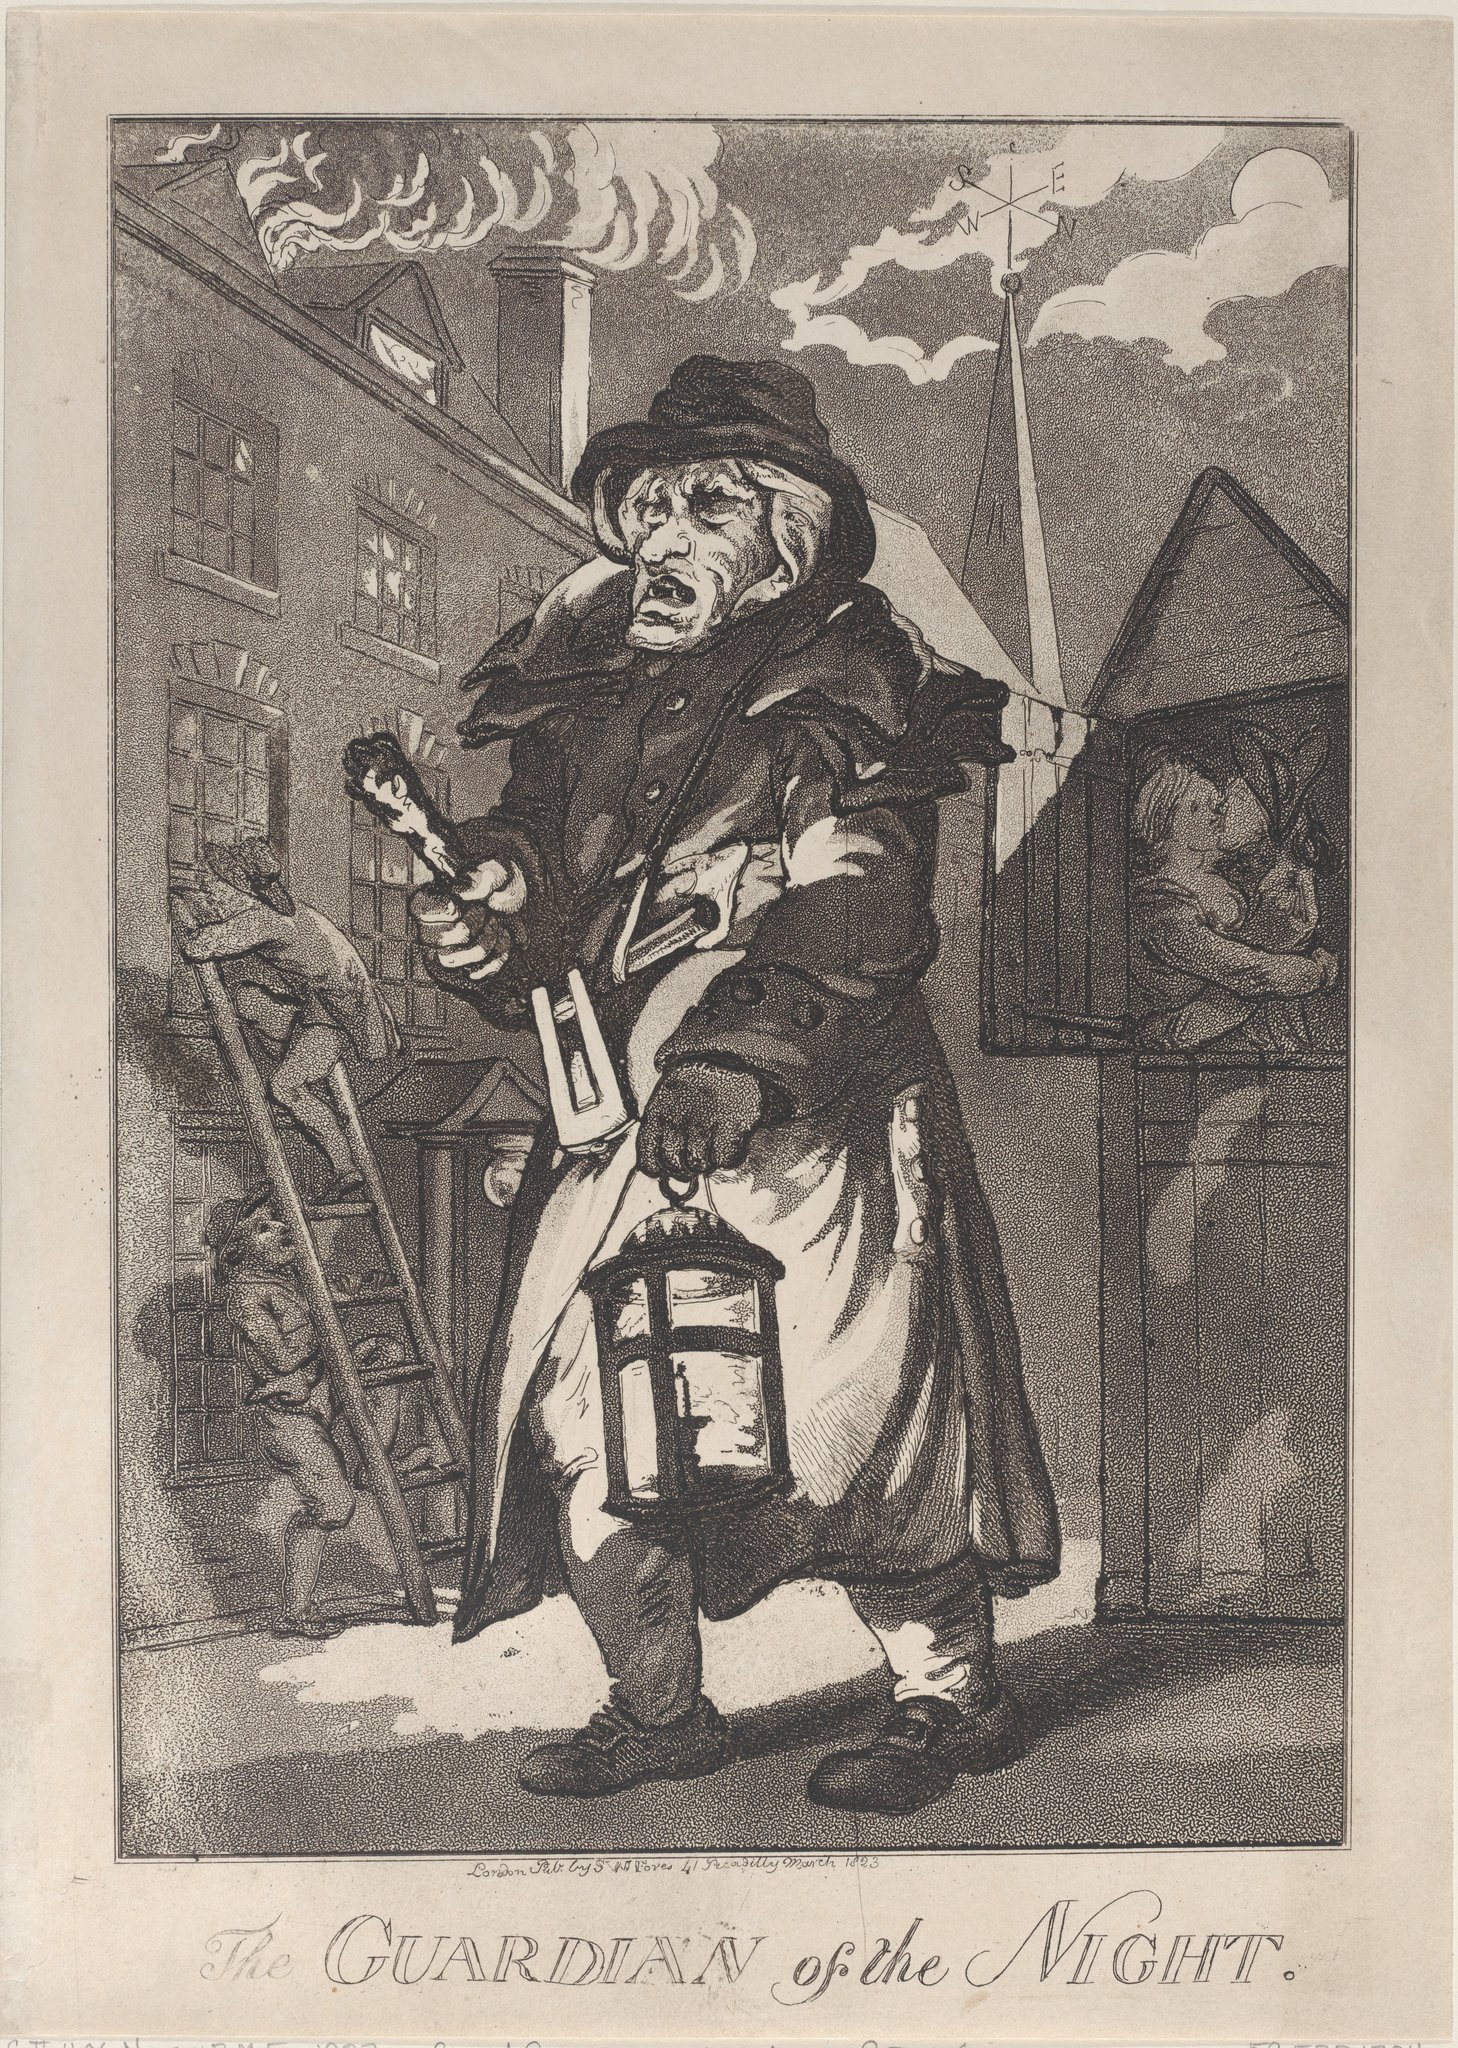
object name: print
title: The Guardian of the Night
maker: thomas rowlandson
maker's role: artist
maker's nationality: british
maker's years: 1757-1827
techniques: aquatint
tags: satire,men,women